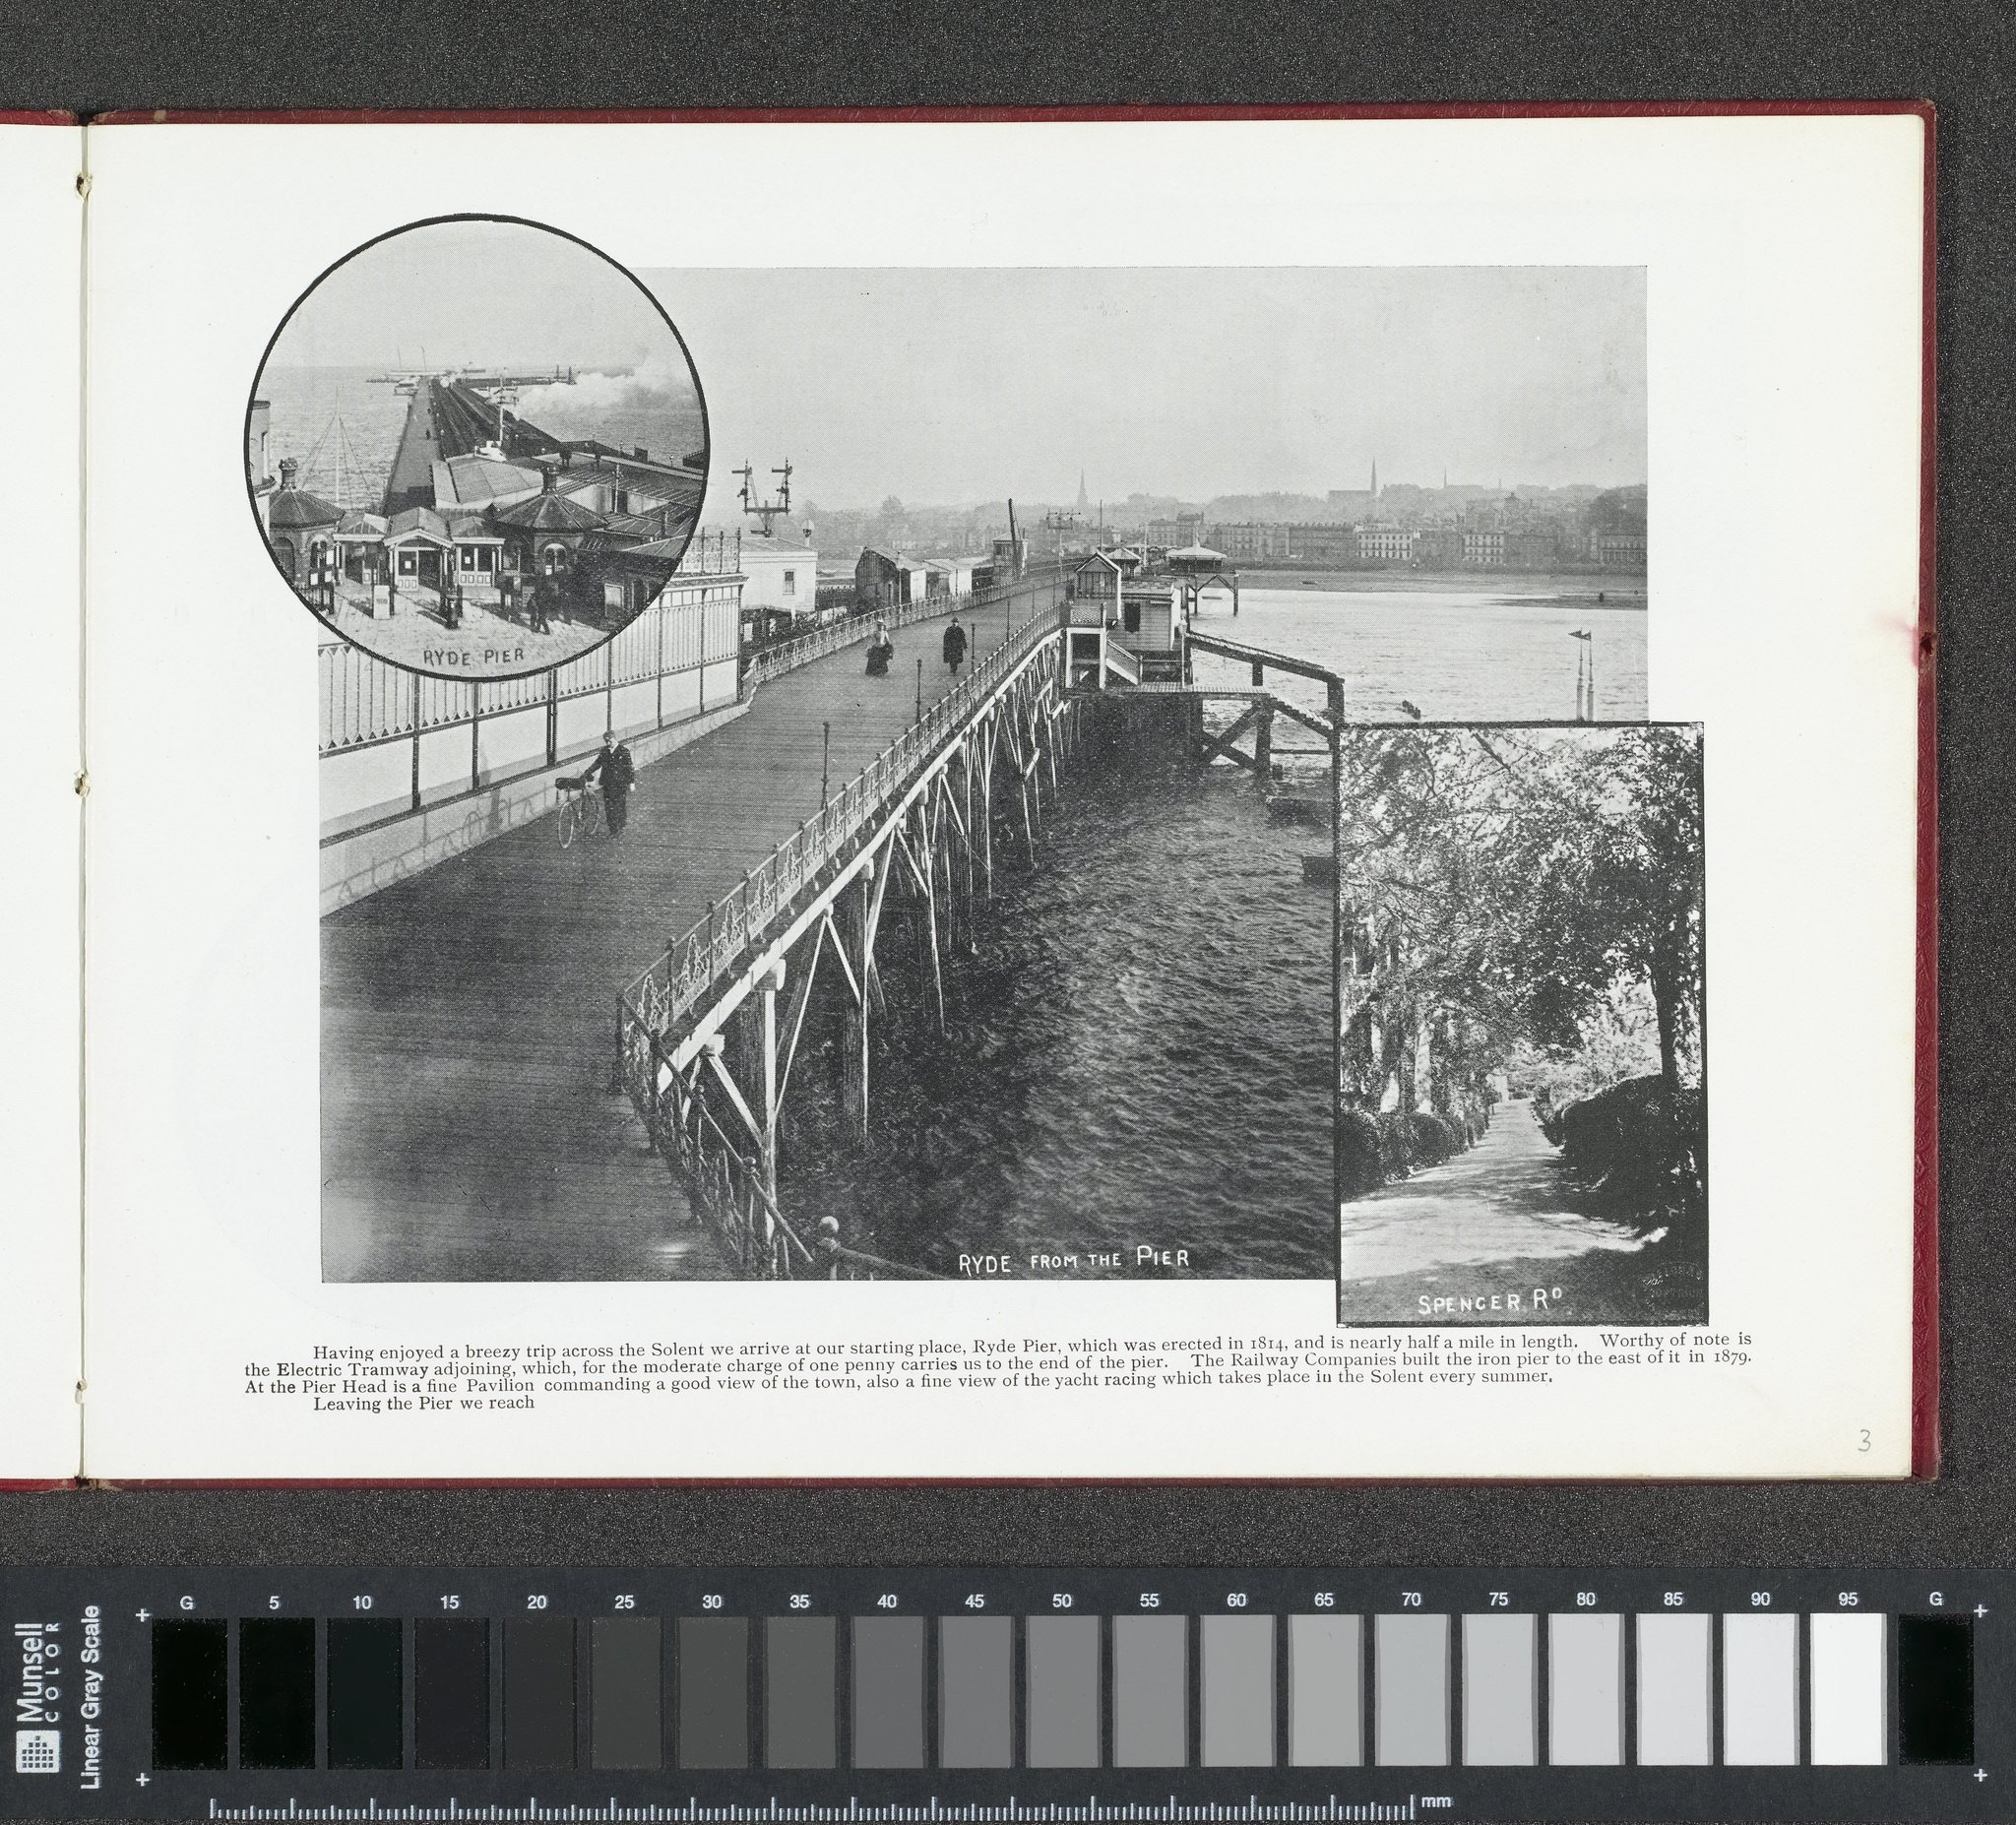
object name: page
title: Ryde Pier en Spencer Road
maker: Anonymous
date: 1897-1930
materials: paper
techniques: printing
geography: st helens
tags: travelling; tourism, pier, quay, wharf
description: Pagina 3 met 3 foto's van Ryde Pier en Spencer Road en een bijschrift. Onderdeel van Fotografische reisreportage van het eiland Wight.